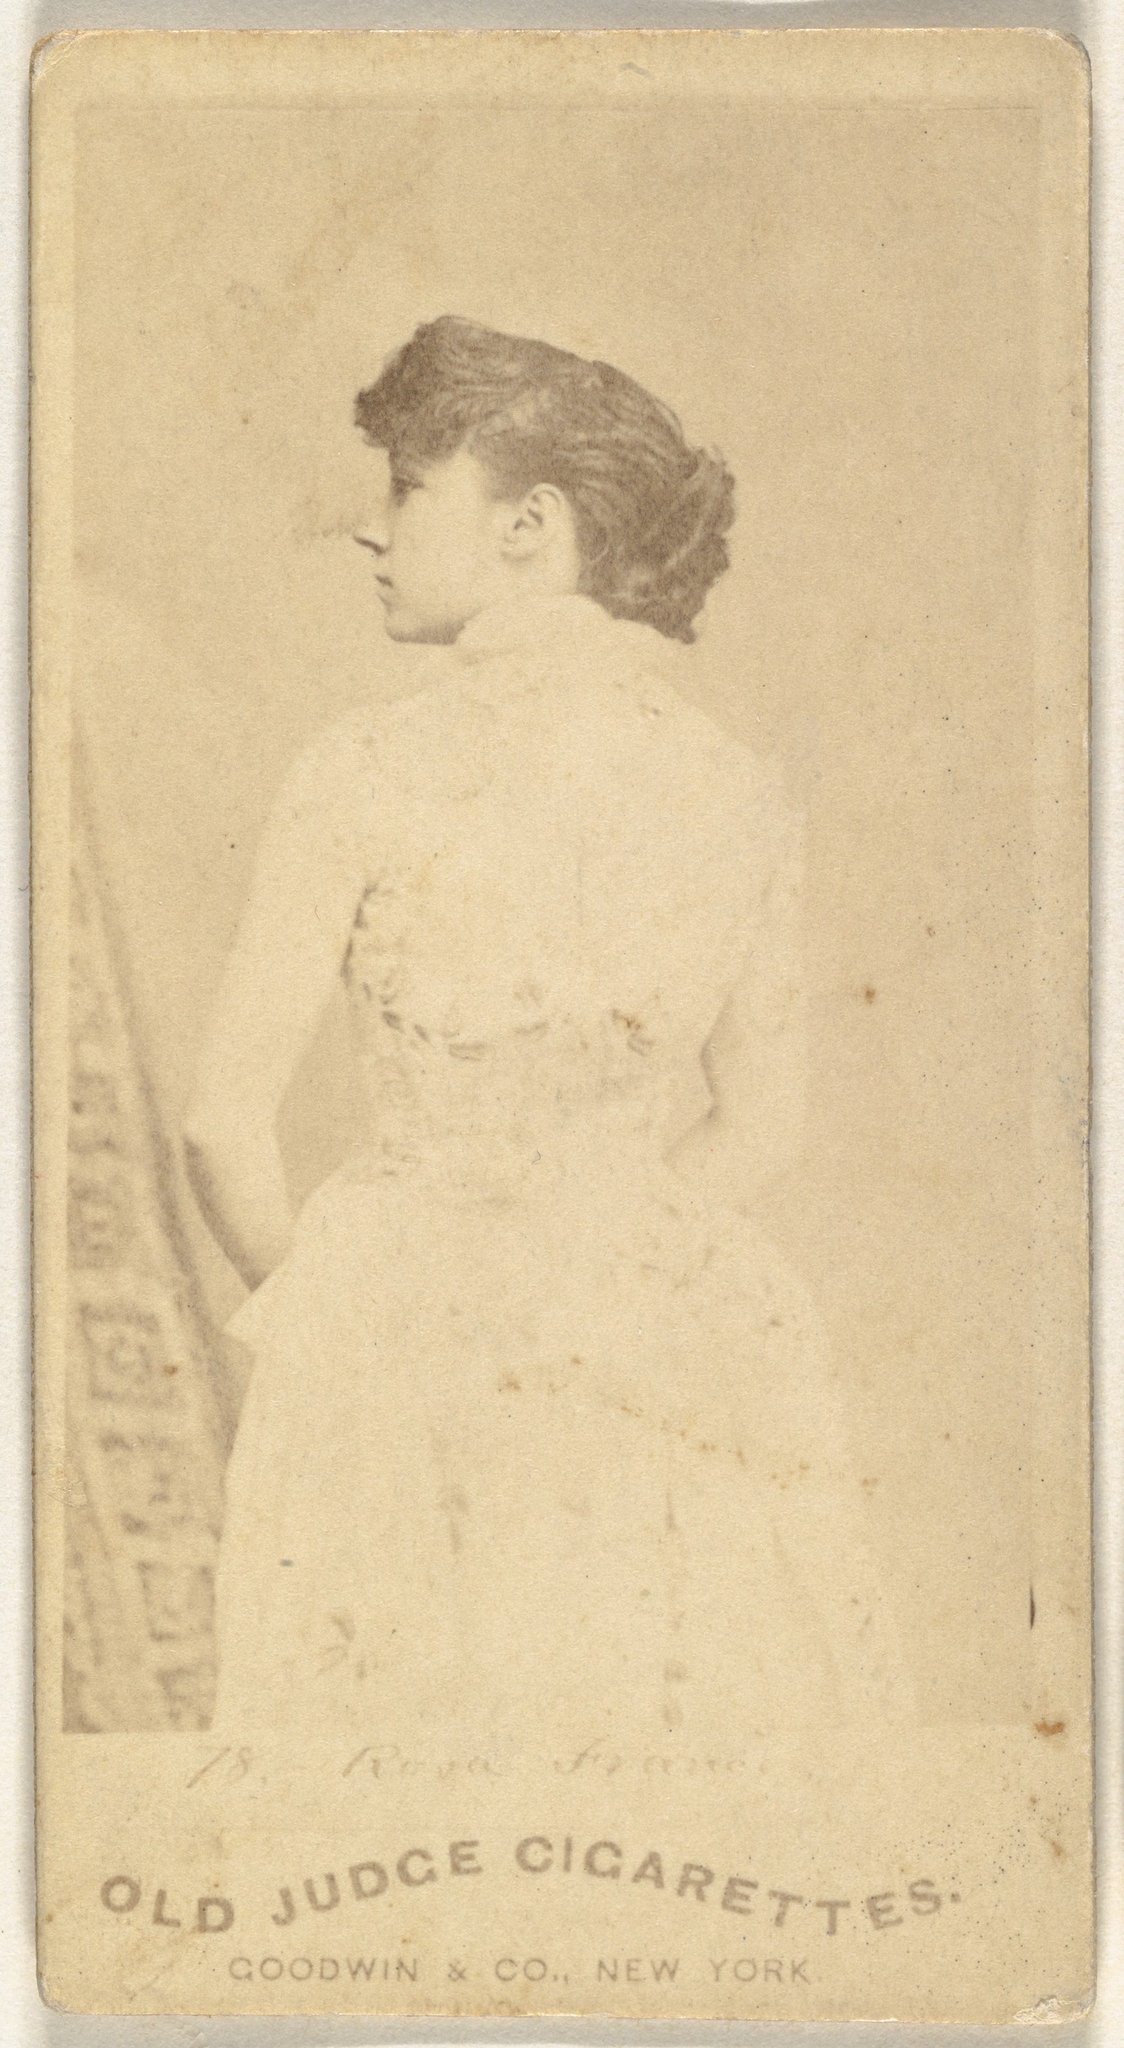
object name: photograph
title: From the Actors and Actresses series (N171) for Old Judge Cigarettes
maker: goodwin & company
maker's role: publisher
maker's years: 1850-1950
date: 1886-1890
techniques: albumen silver print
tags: portraits,women,actresses